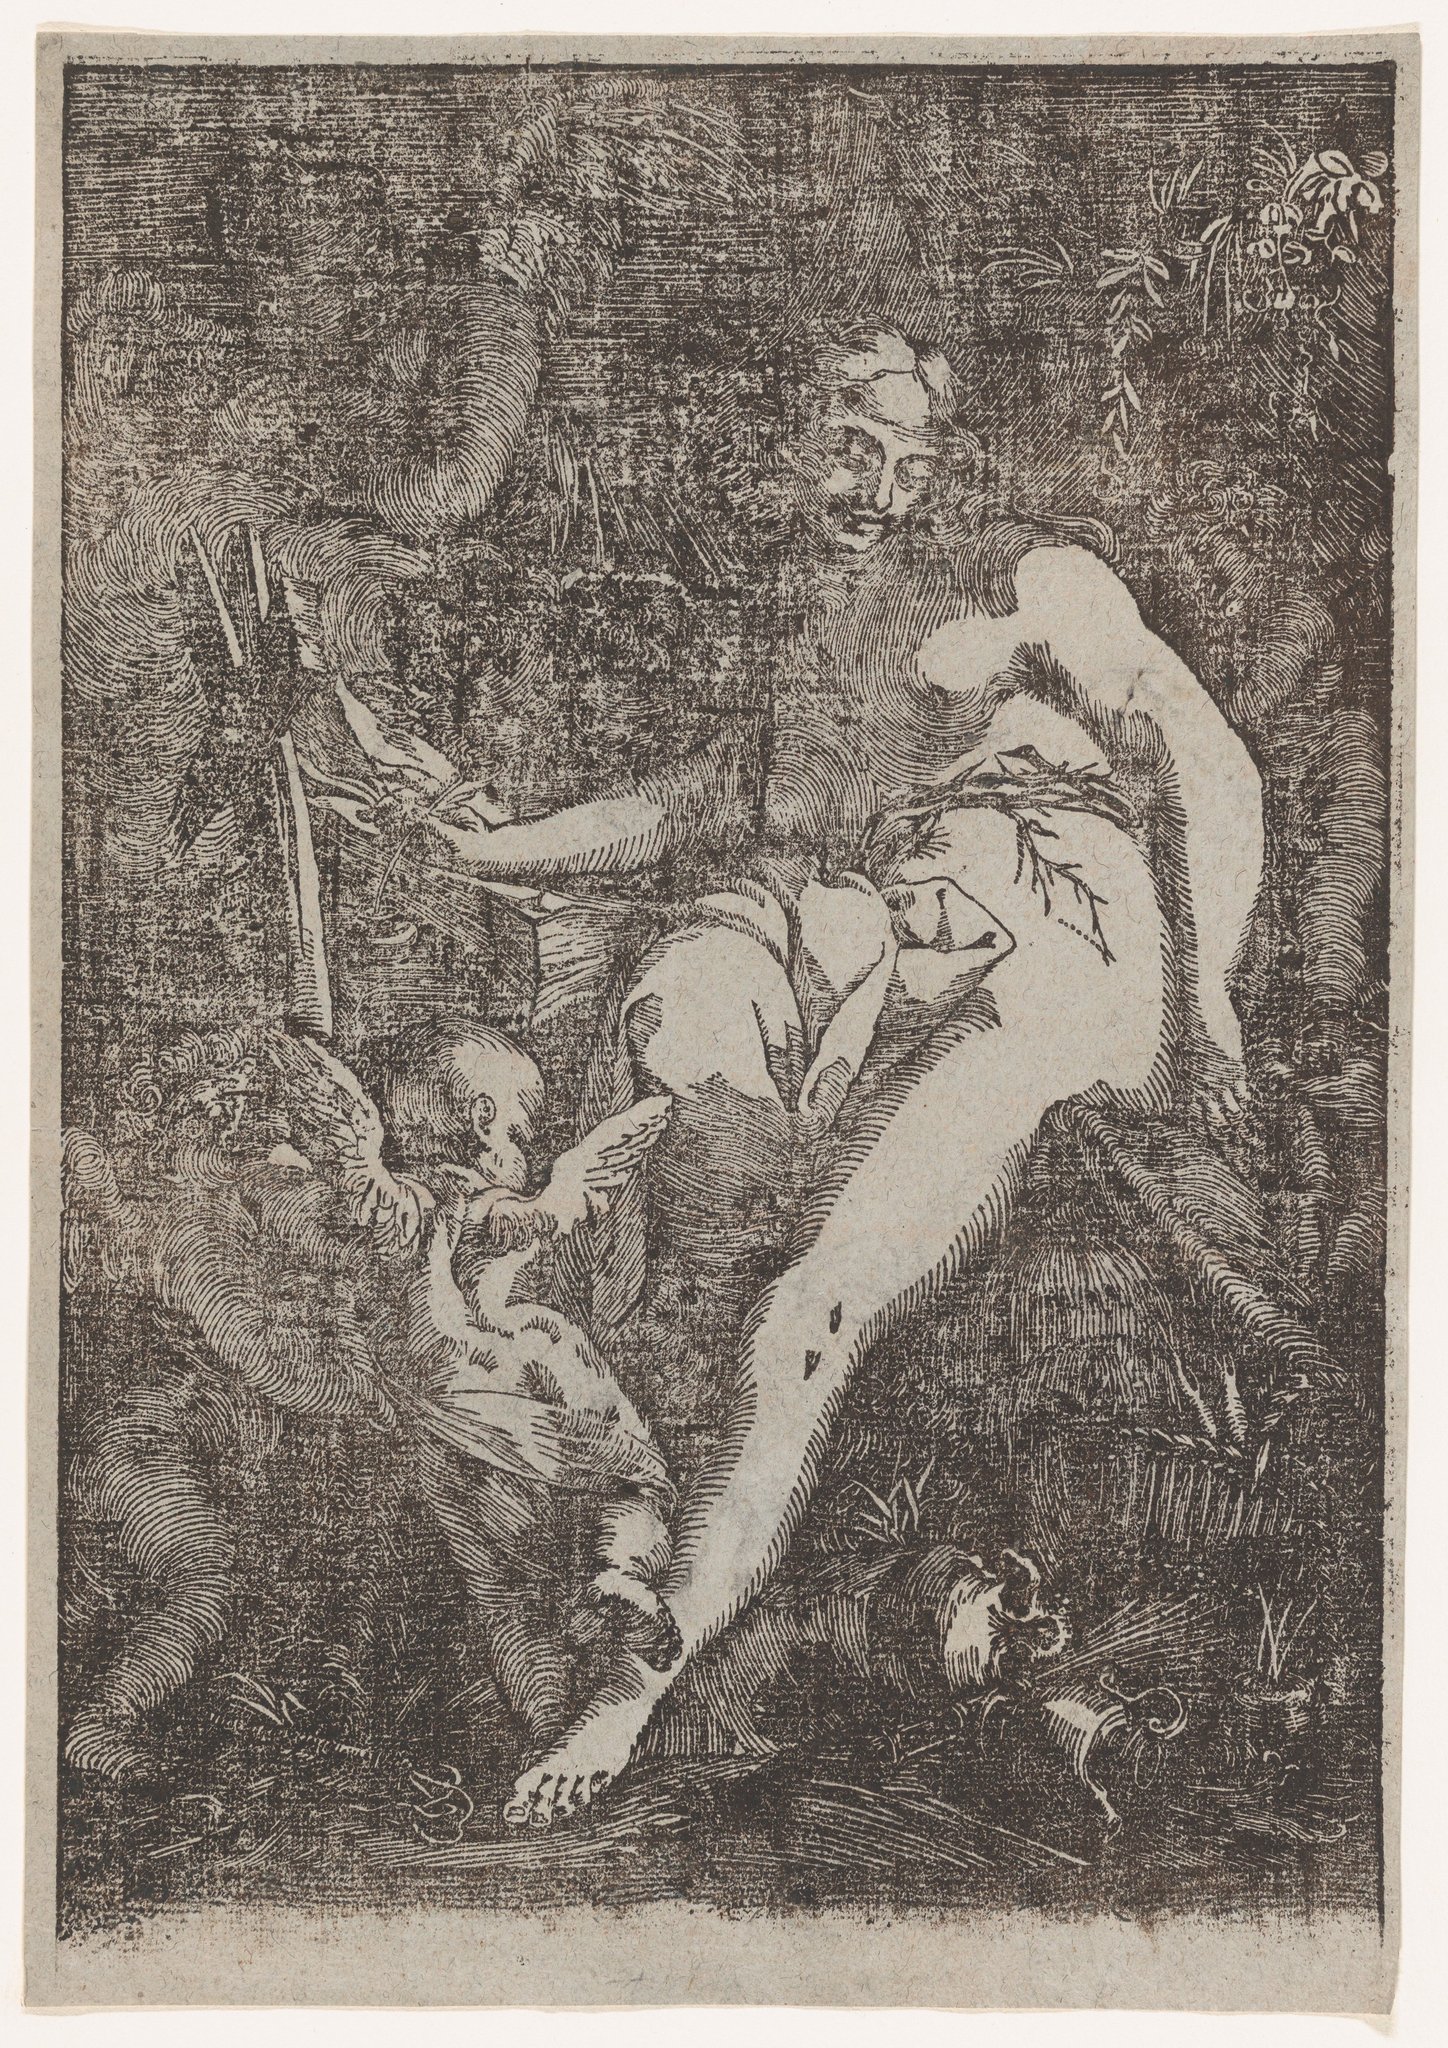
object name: print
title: Saint Mary Magdalene in Penitence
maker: giuseppe scolari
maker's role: artist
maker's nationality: italian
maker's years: 1562-1607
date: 1590-1607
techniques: woodcut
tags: putti,mary magdalene